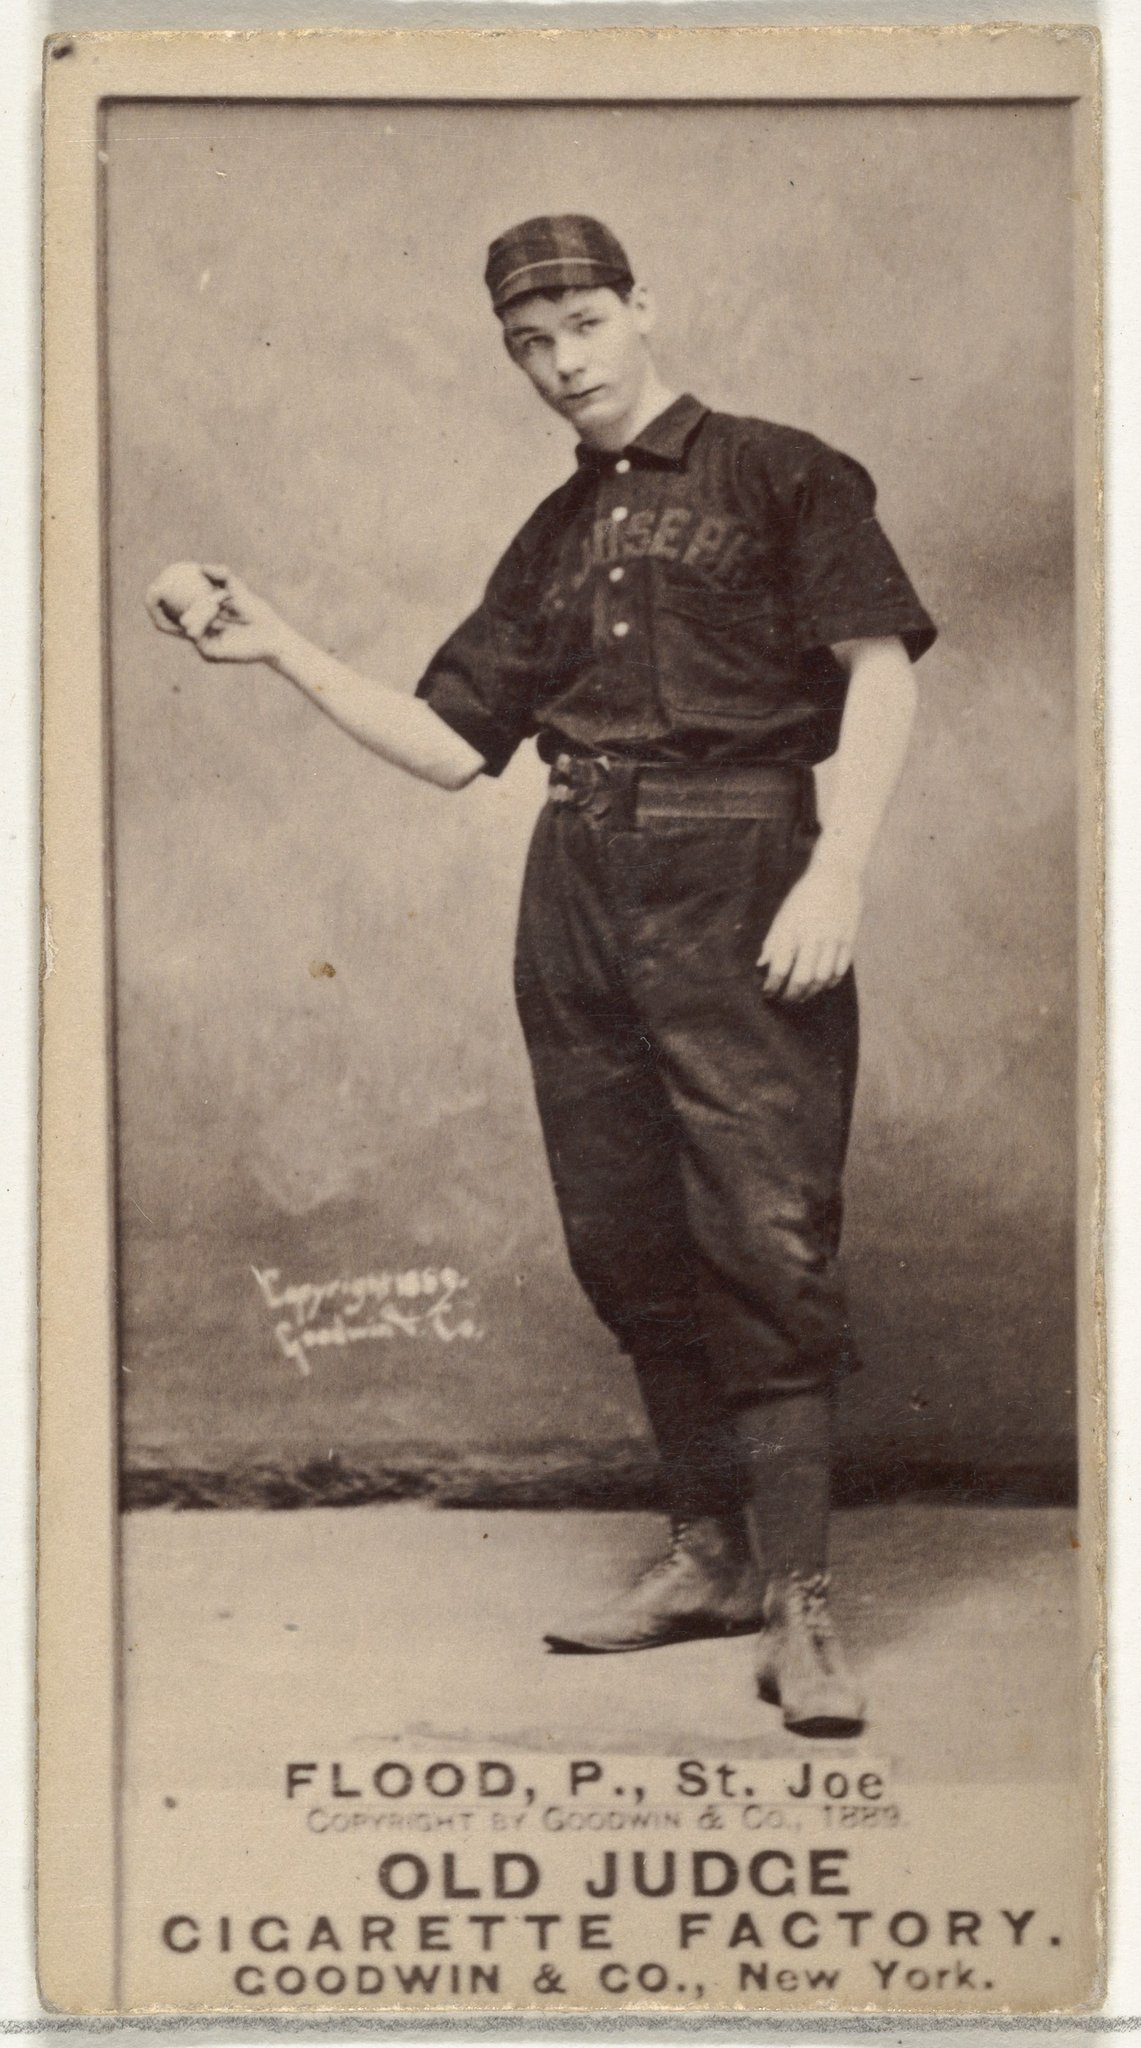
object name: baseball card, photograph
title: Thomas J. Flood, Pitcher, St. Joseph Clay Eaters, from the Old Judge series (N172) for Old Judge Cigarettes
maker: goodwin & company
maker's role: publisher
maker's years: 1850-1950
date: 1889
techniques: albumen silver print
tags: men,portraits,baseball,athletes